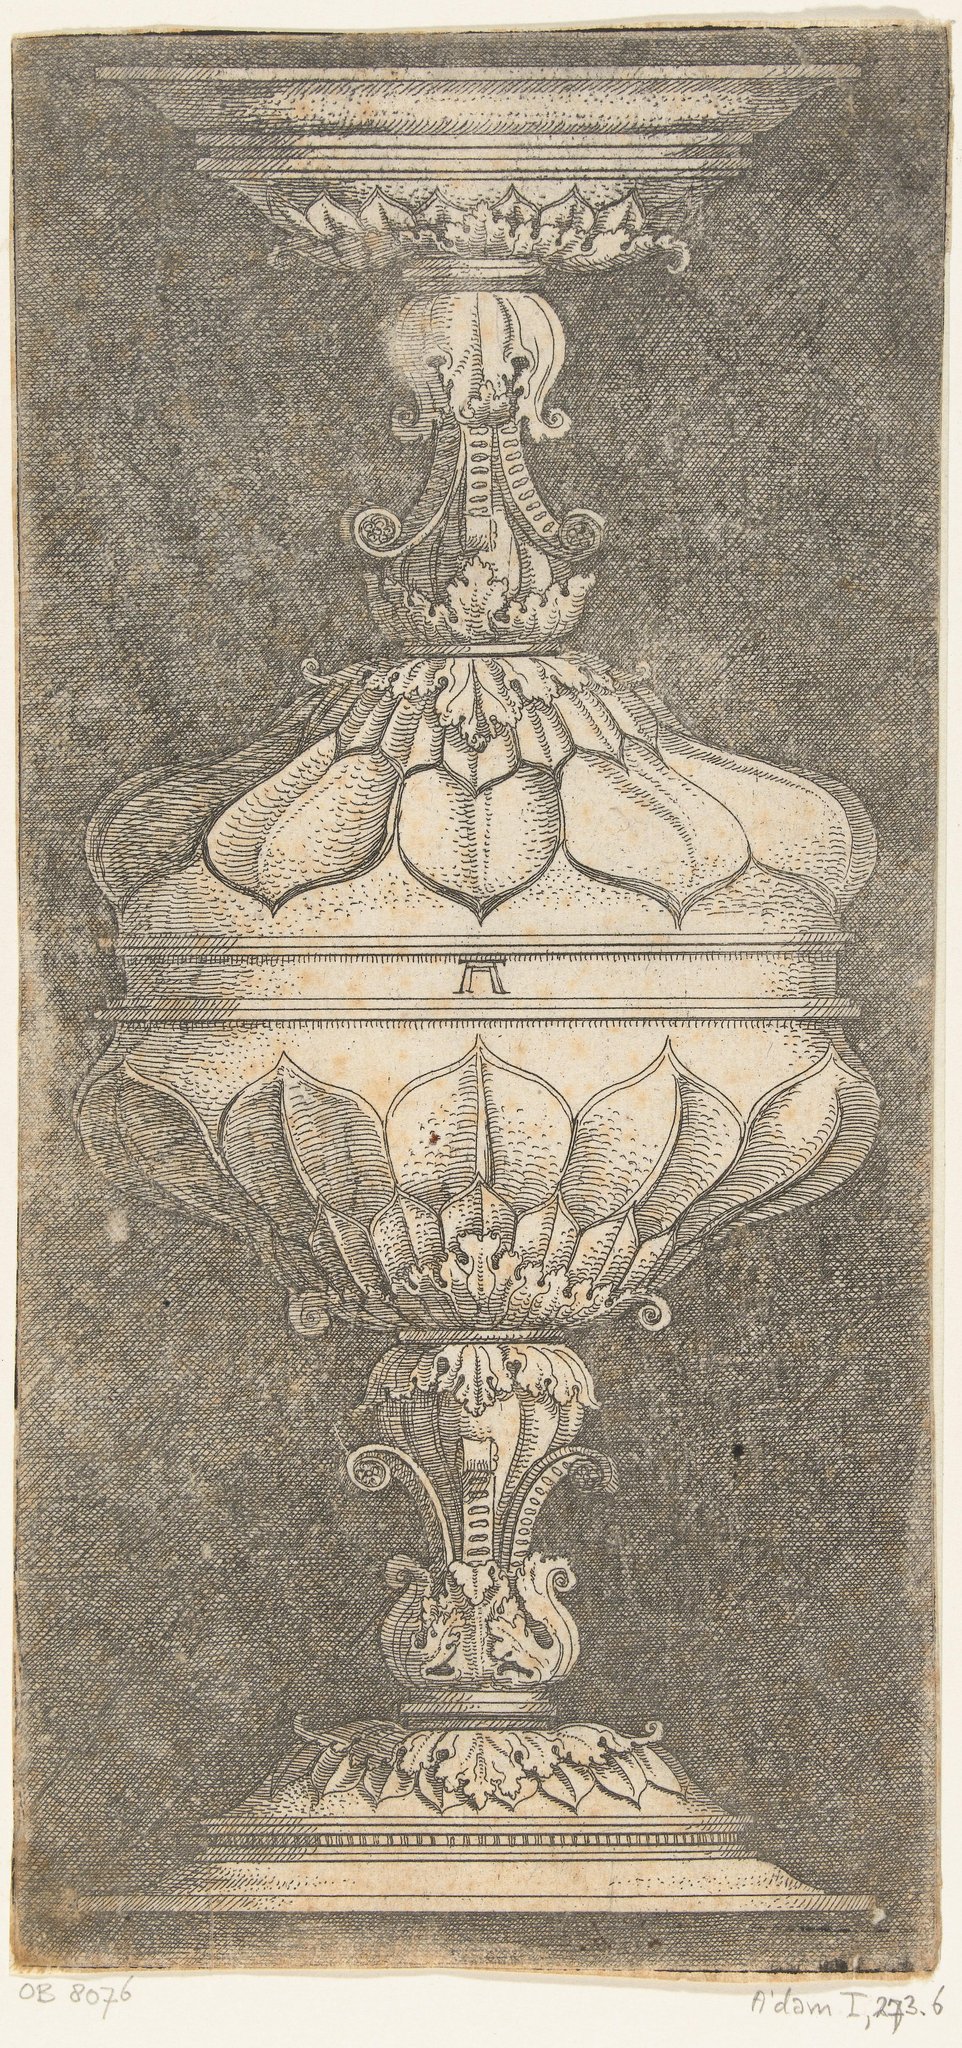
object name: ornament print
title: Dubbele bokaal, gedecoreerd met bladeren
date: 1490-1538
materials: paper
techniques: etching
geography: regensburg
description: Eén van 11 bladen uit een serie van 22. Gearceerde achtergrond.